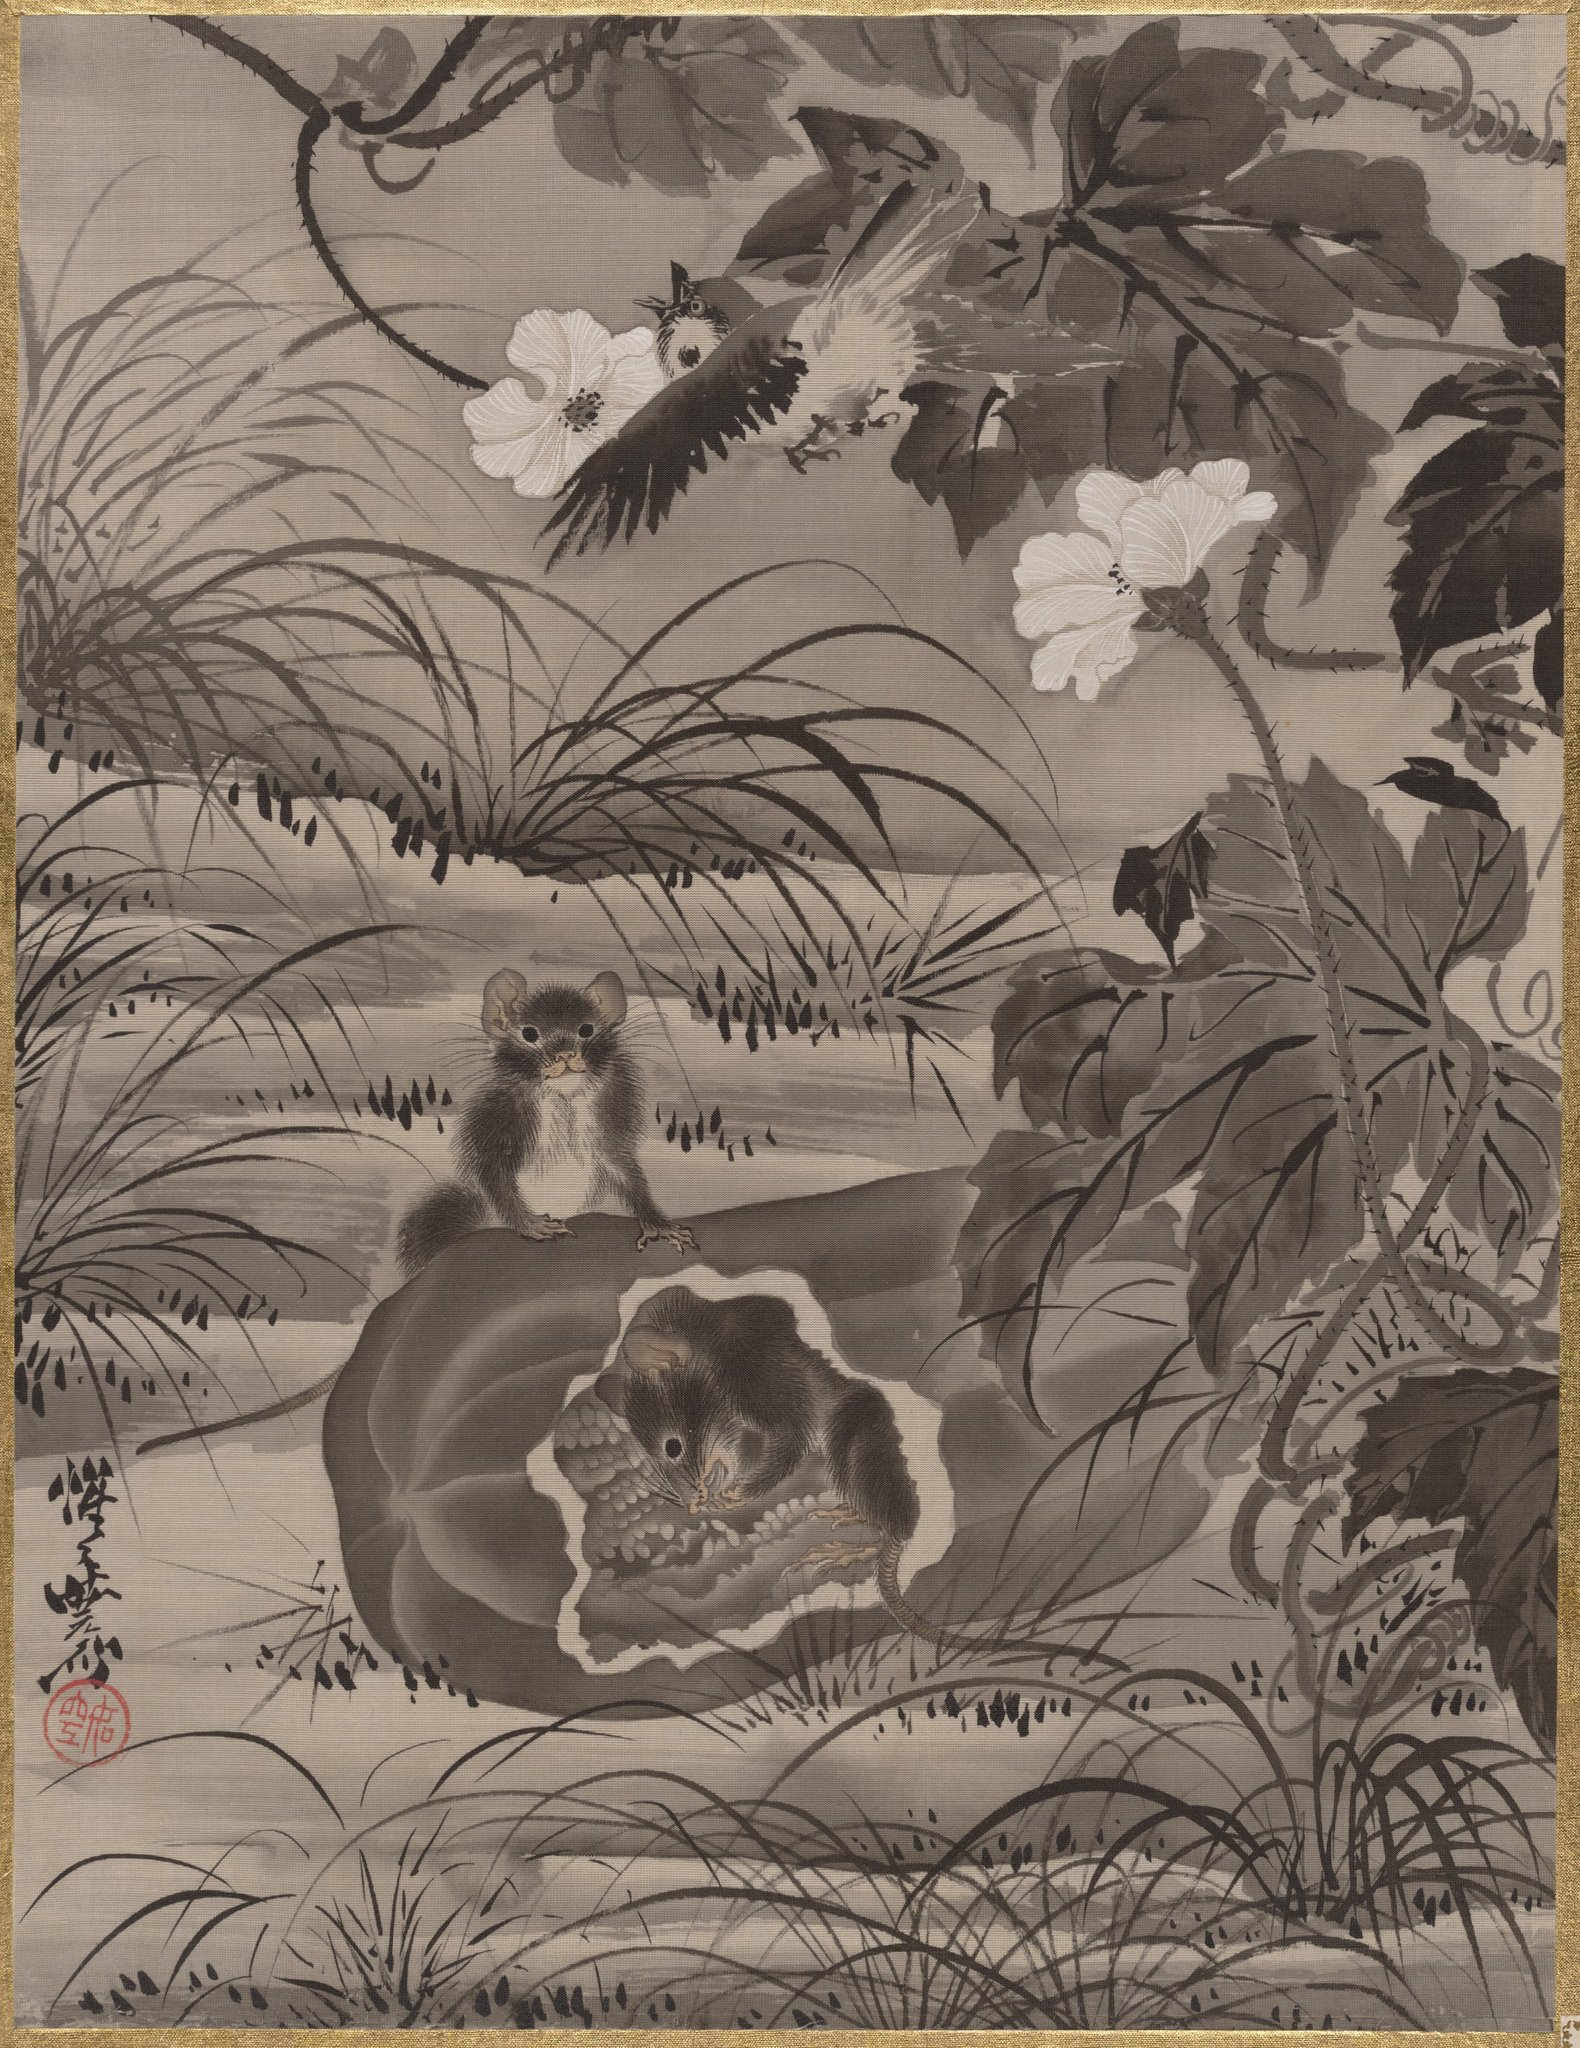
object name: album leaf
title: Rats and Gourd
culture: japanese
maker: kawanabe kyōsai 河鍋暁斎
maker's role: artist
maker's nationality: japanese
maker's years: 1831-1889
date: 1887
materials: ink, silk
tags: birds,rats,gourds